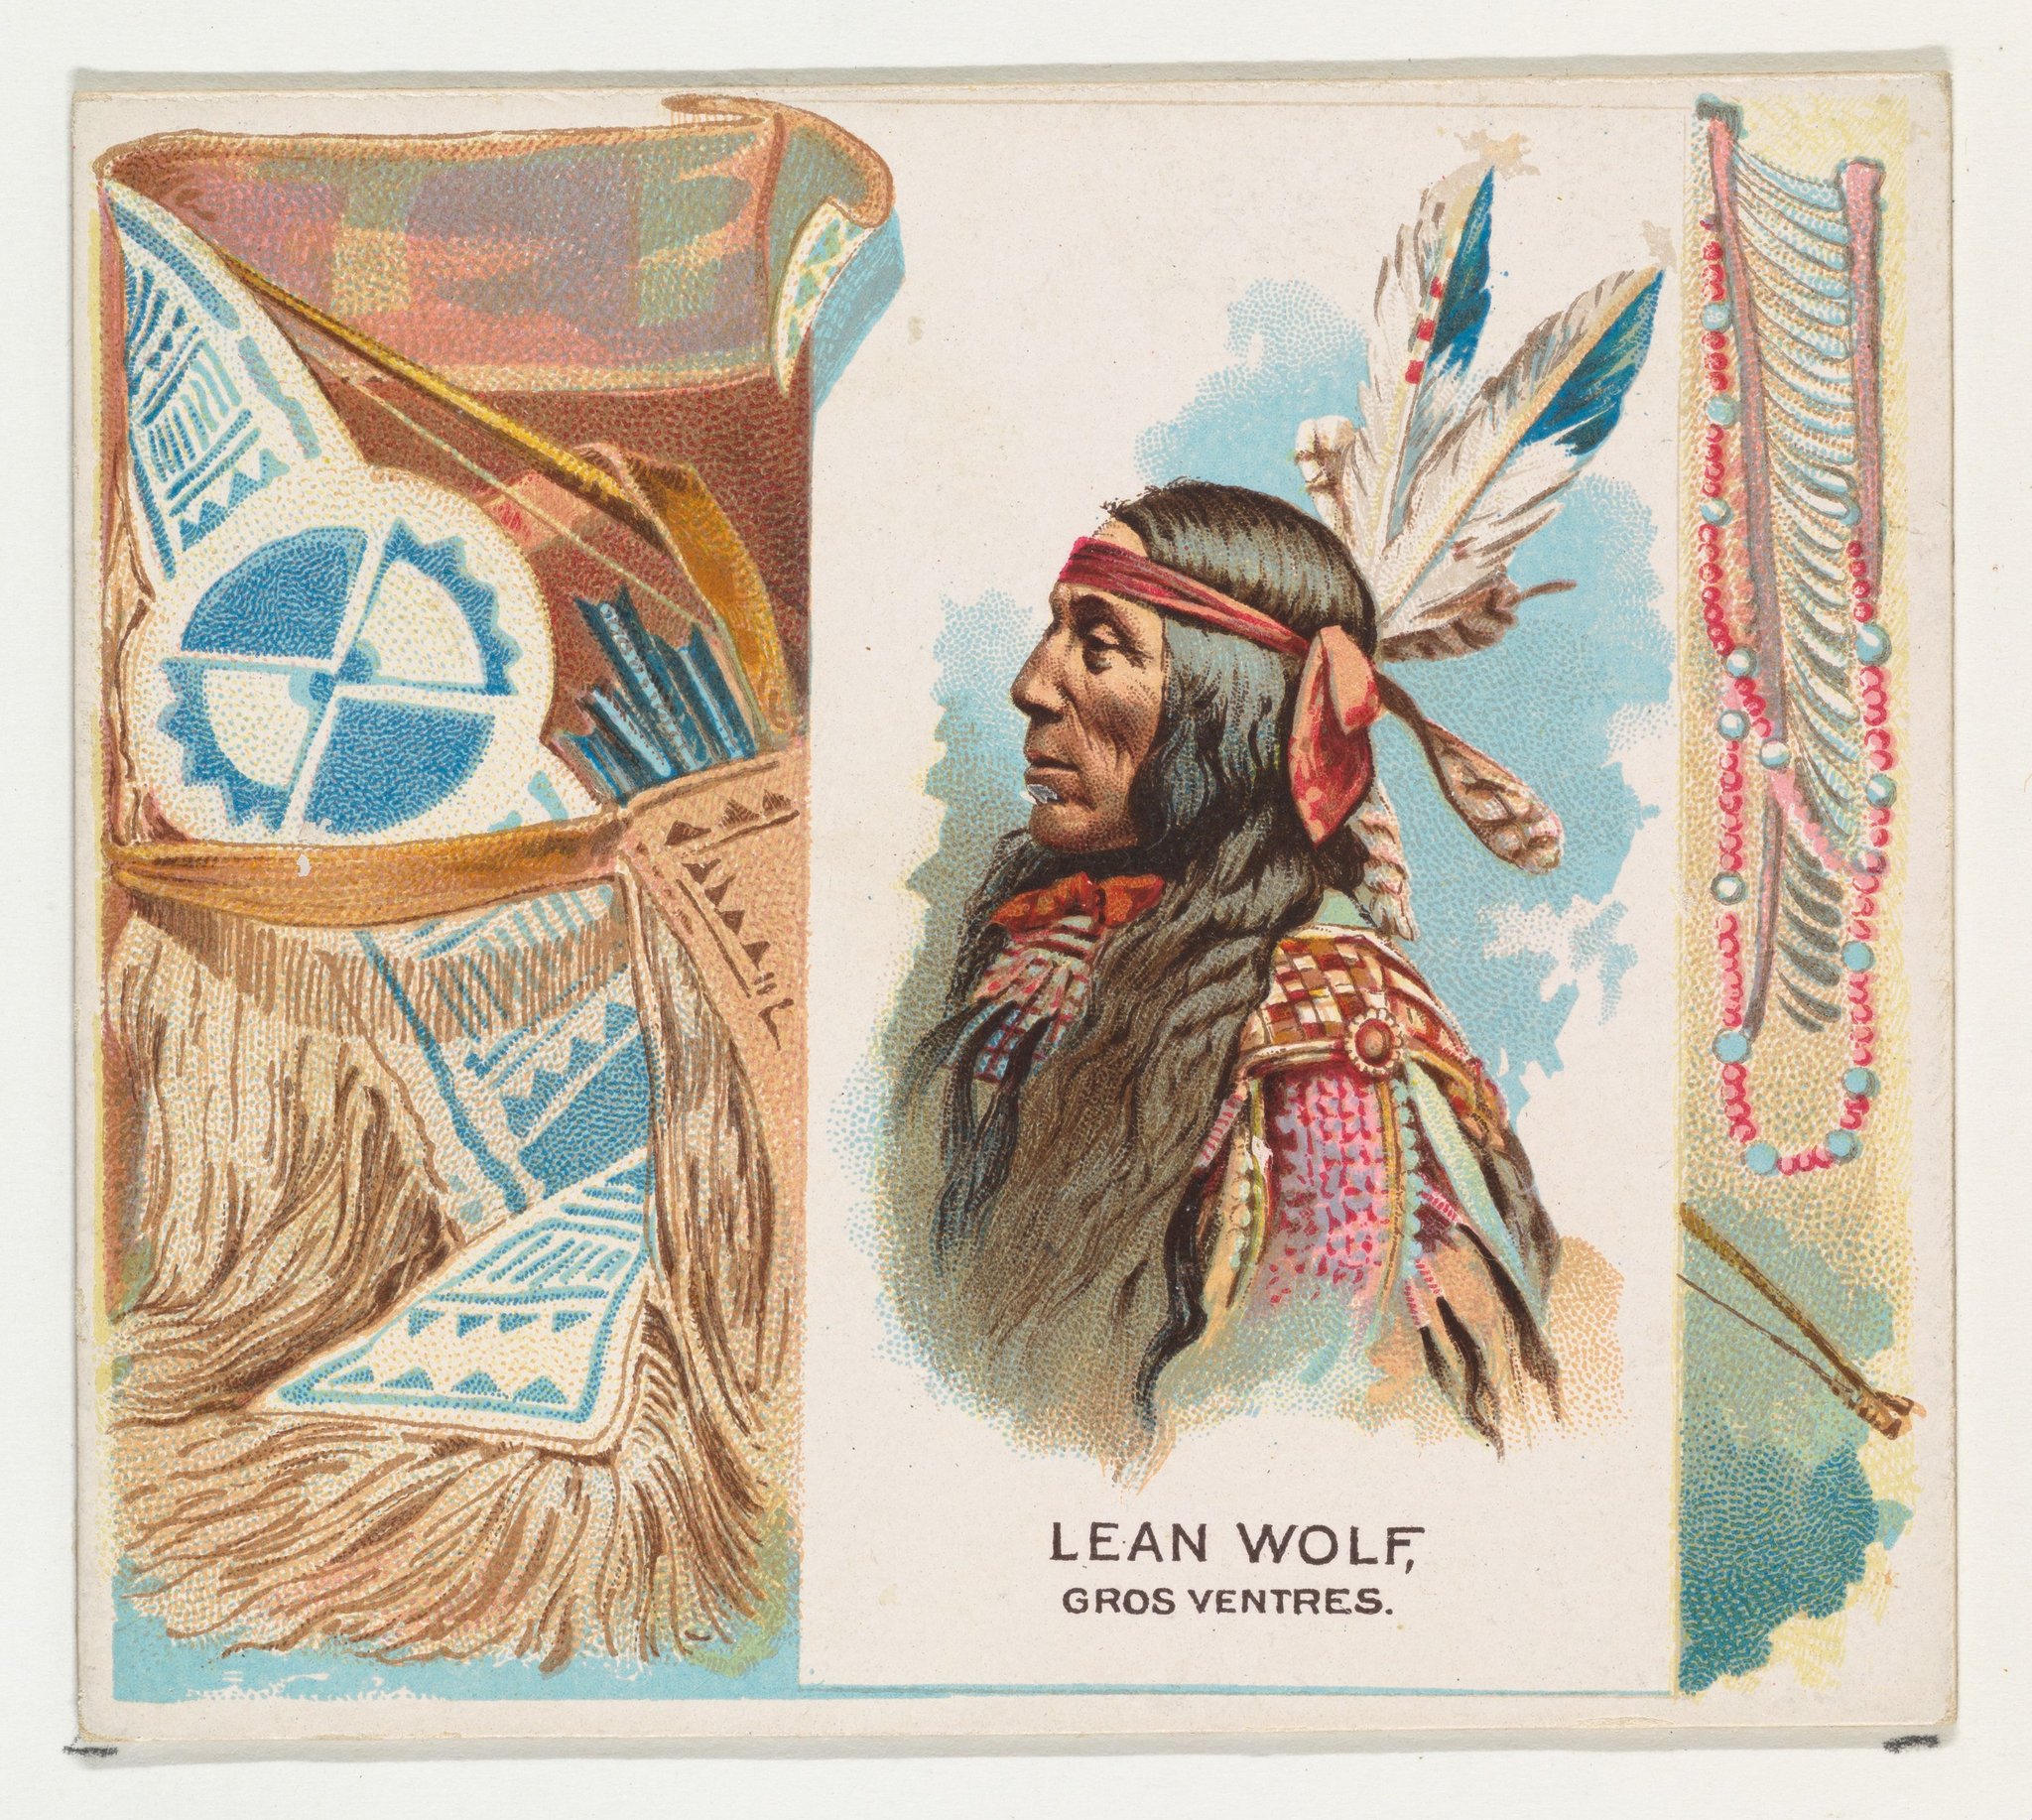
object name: print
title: Lean Wolf, Gros Ventres, from the American Indian Chiefs series (N36) for Allen & Ginter Cigarettes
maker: allen & ginter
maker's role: publisher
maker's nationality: american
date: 1888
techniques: color lithograph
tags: men,profiles